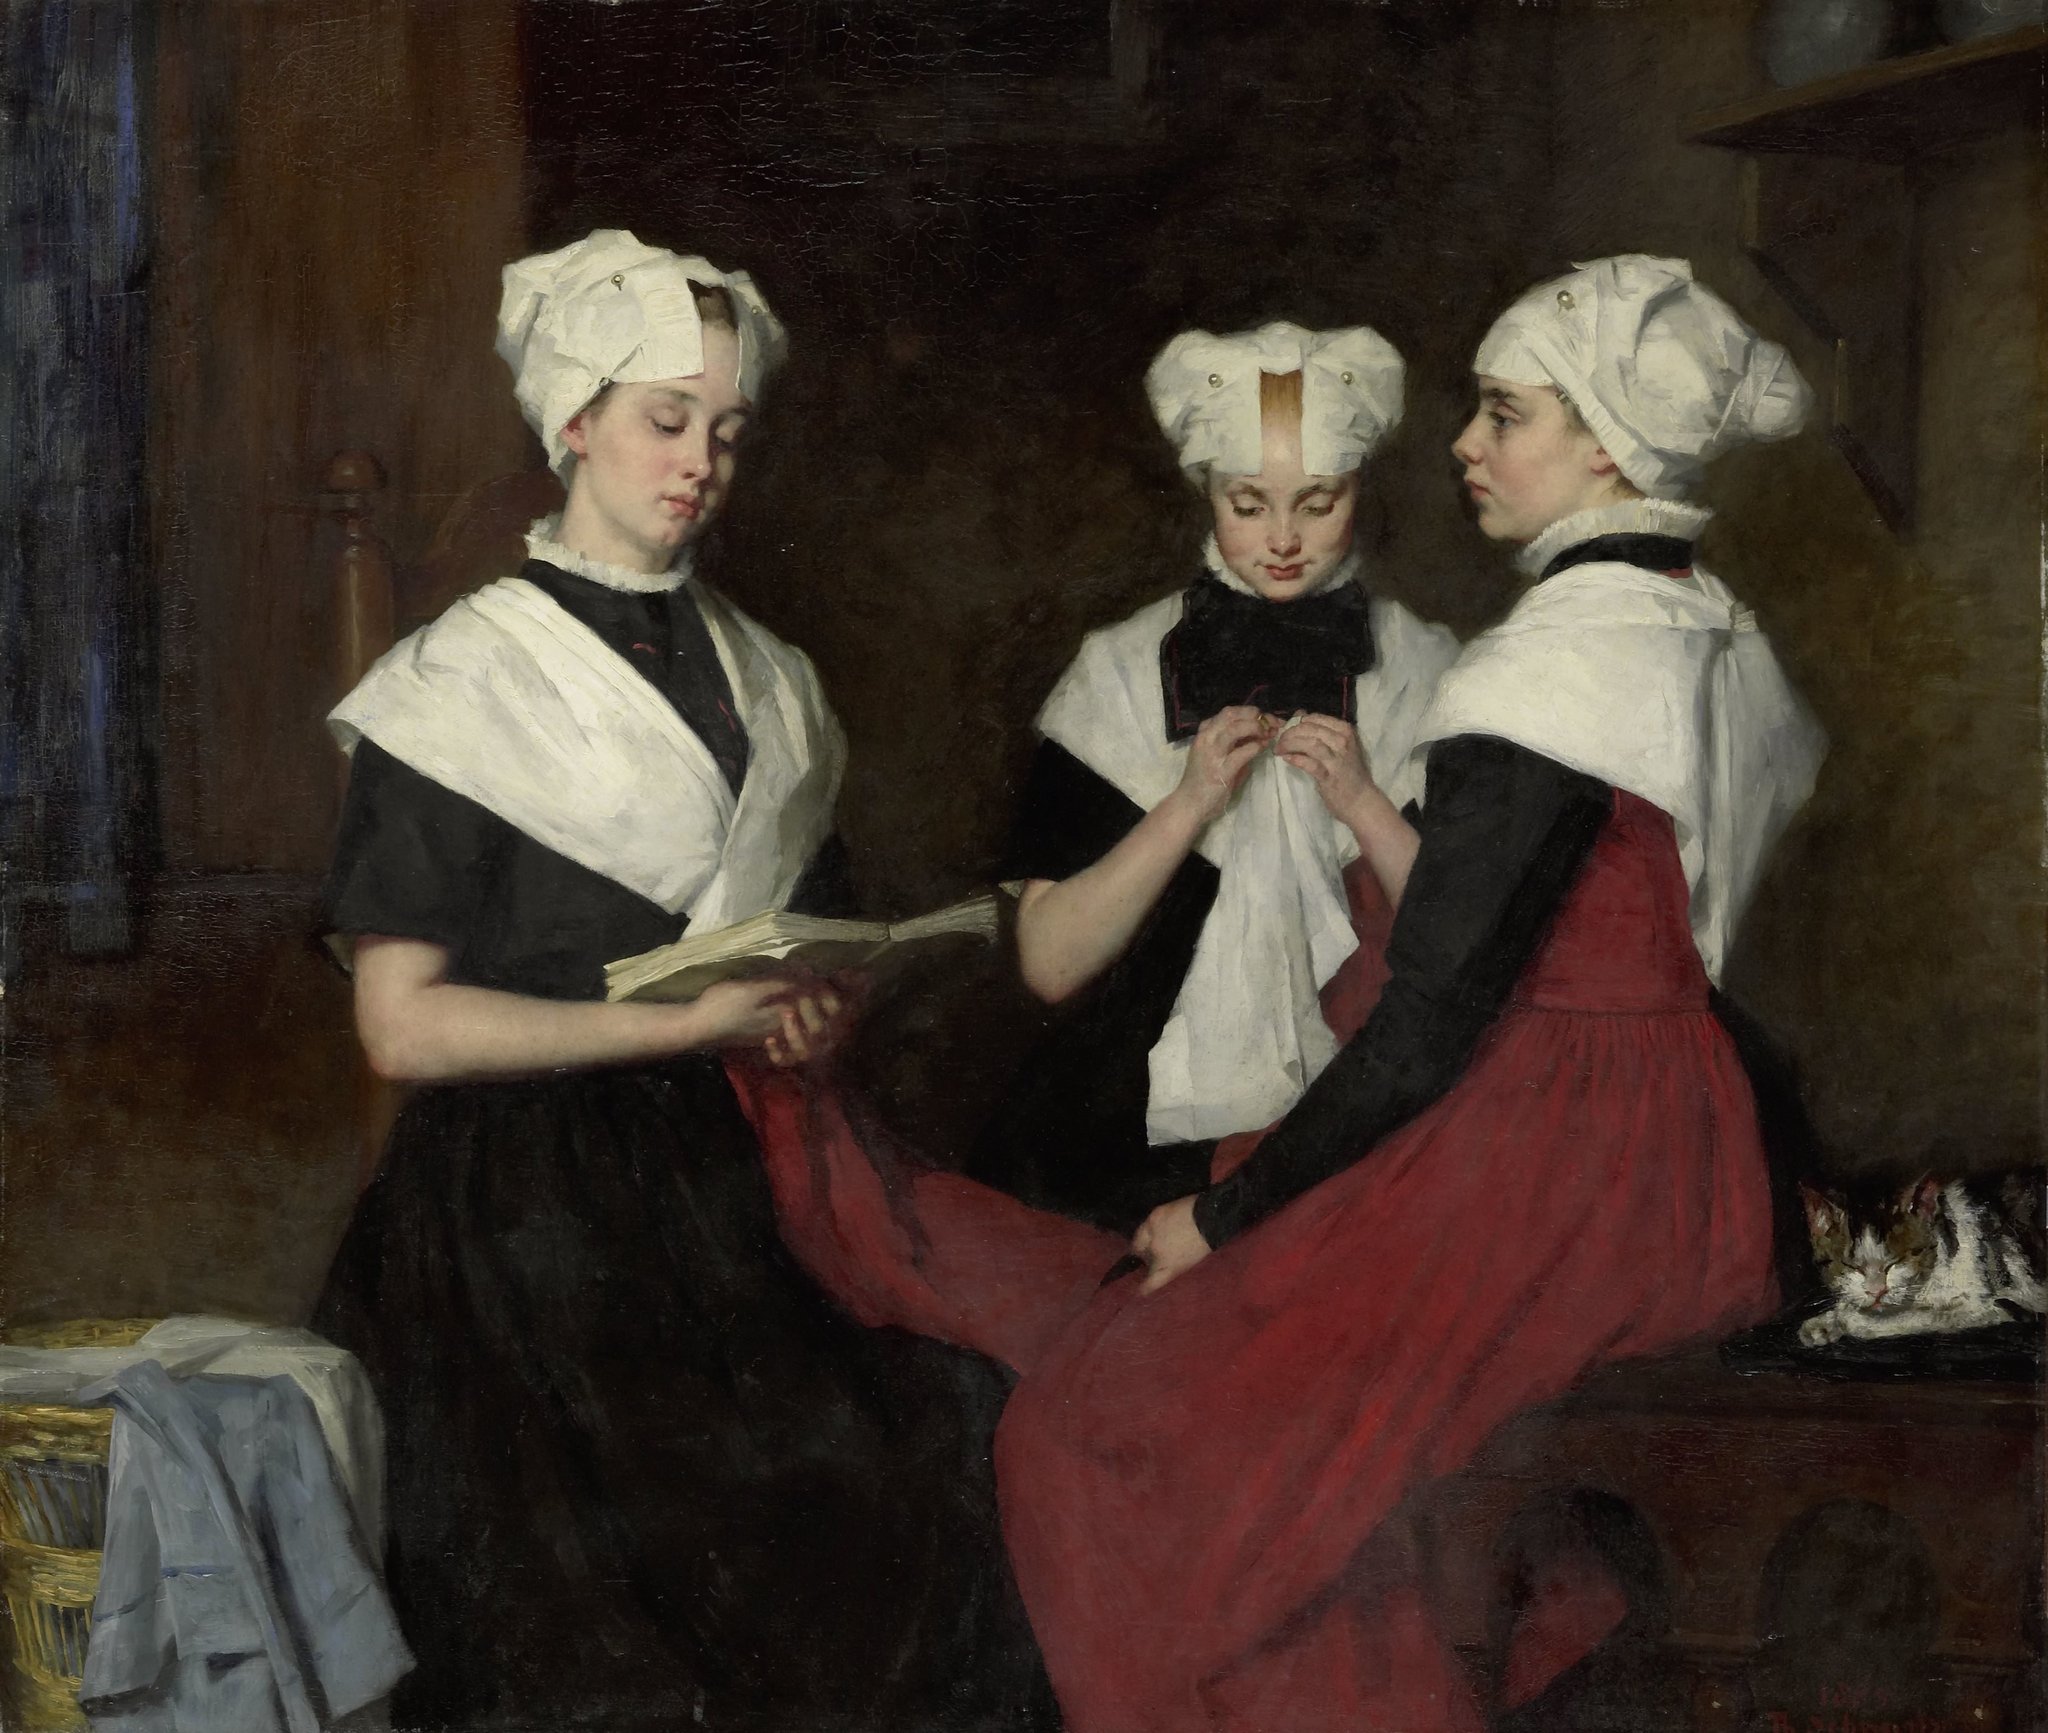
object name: painting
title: Drie meisjes uit het Amsterdamse Burgerweeshuis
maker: thérèse schwartze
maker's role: draughtsman, painter, print maker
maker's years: 1851-1918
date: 1885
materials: canvas, oil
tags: historical persons not known by name - bb - woman, orphanage, orphans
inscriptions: signature and date: ‘Th. Schwartze 1885’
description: Drie meisjes uit het Amsterdamse Burgerweeshuis, één leest voor uit een boek terwijl een ander luistert en een ander bezig met verstelwerk is. Links een wasmand, rechts slaapt een kat op een bankje.